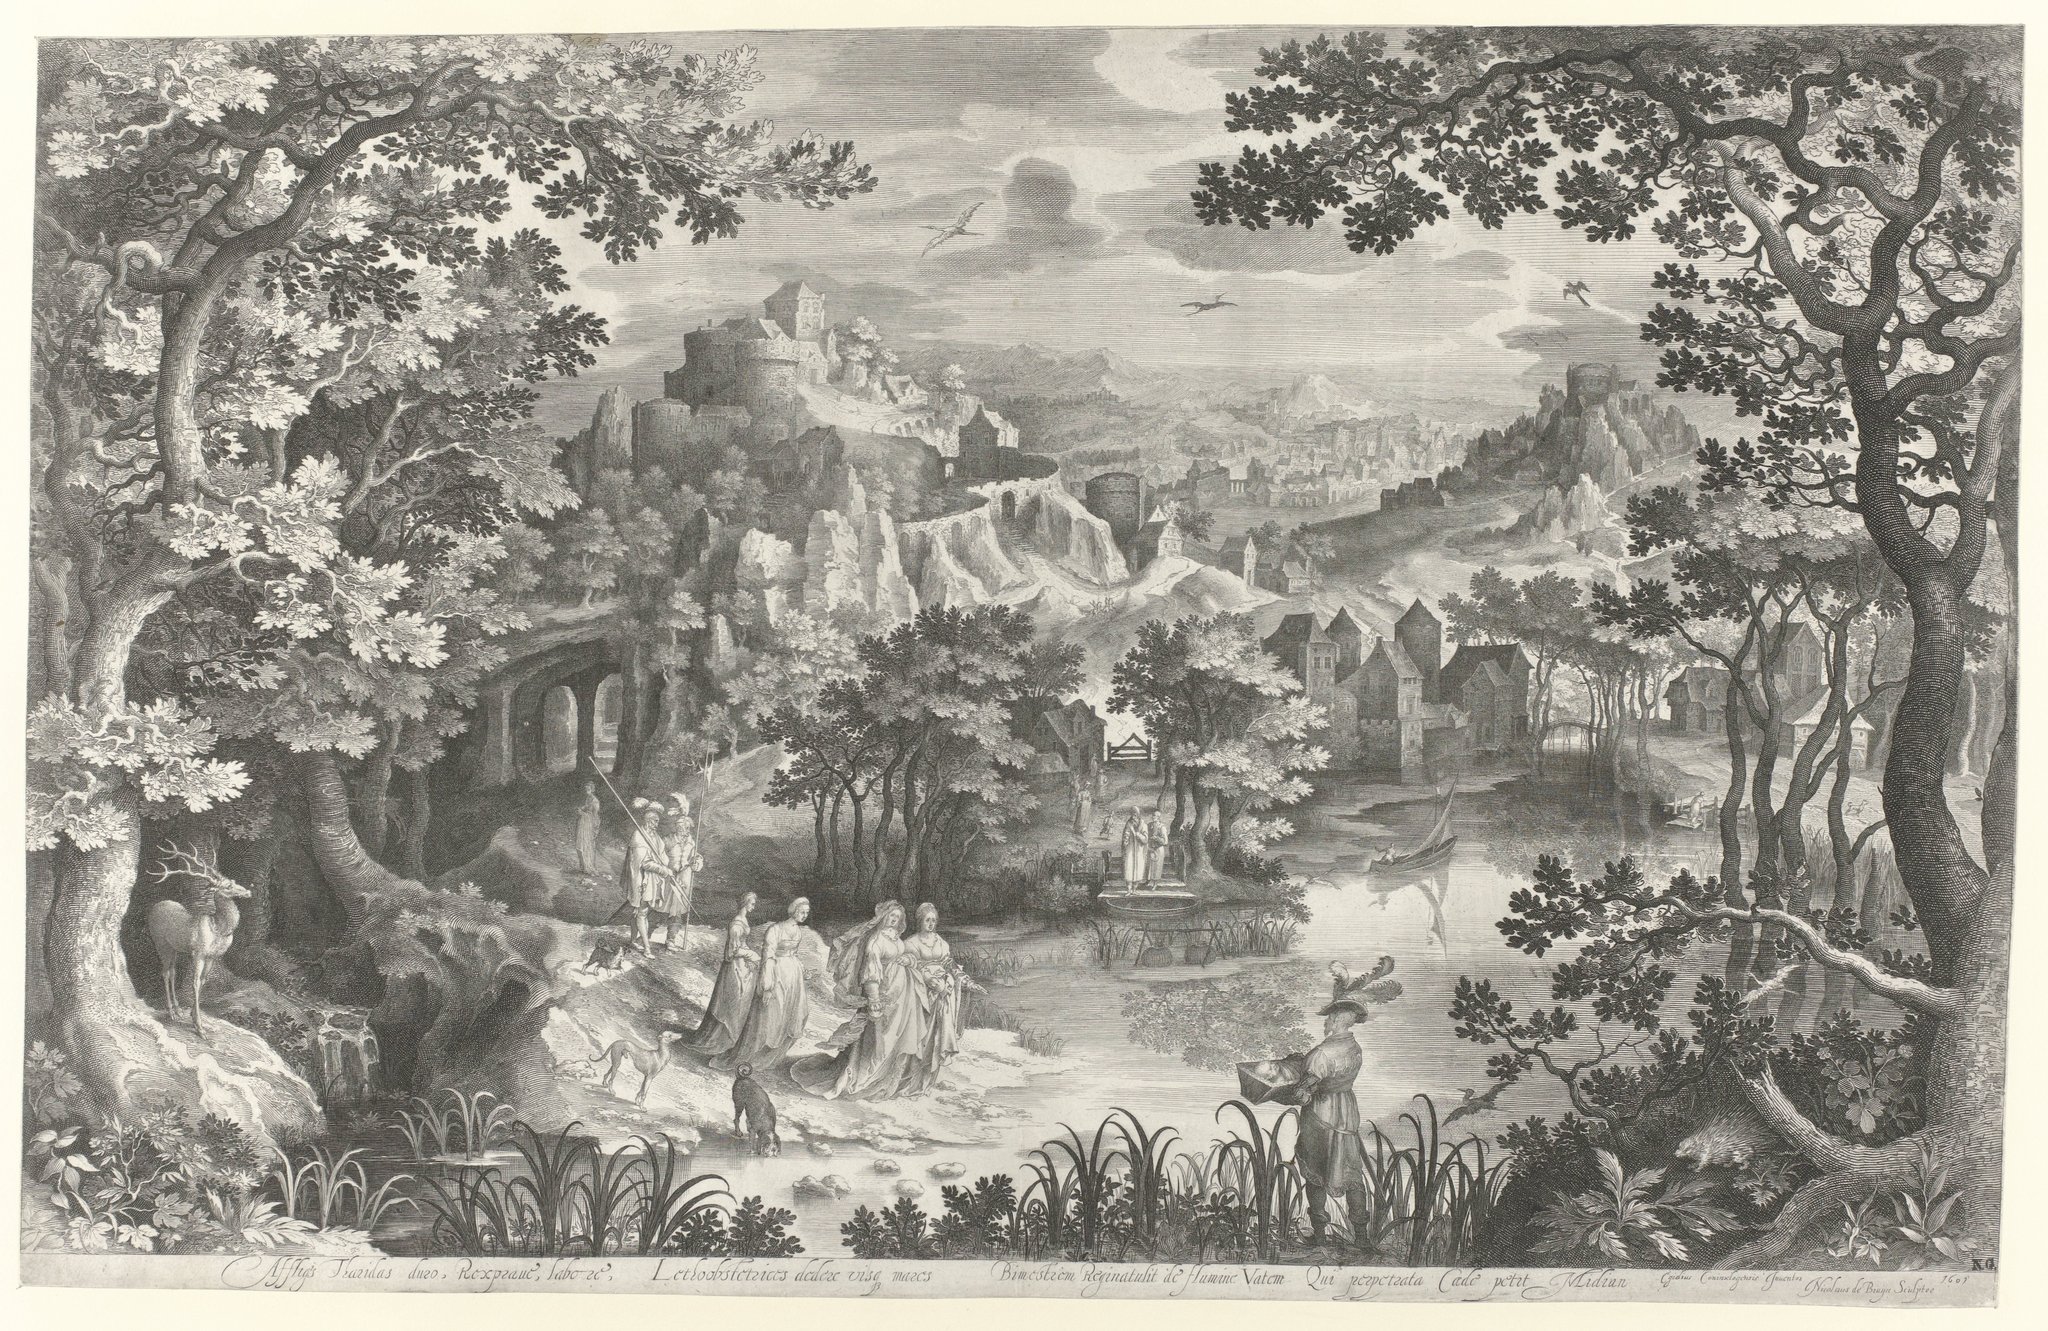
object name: print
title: Mozes wordt gevonden door de dochter van de farao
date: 1601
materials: paper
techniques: engraving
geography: antwerp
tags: moses is pulled out of the water by the servants, mountains (+ landscape with figures, staffage), the finding of moses: pharaoh's daughter comes to bathe with her maidens in the river and discovers the child floating on the water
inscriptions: collector's mark: Lugt 1967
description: De rivier de Nijl met aan de oever de dochter van de farao en haar dienstmaagden. Op de voorgrond een soldaat met in zijn handen de wieg met het kind Mozes. Op de achtergrond een bergachtig landschap. De prent heeft een Latijns onderschrift met uitleg.